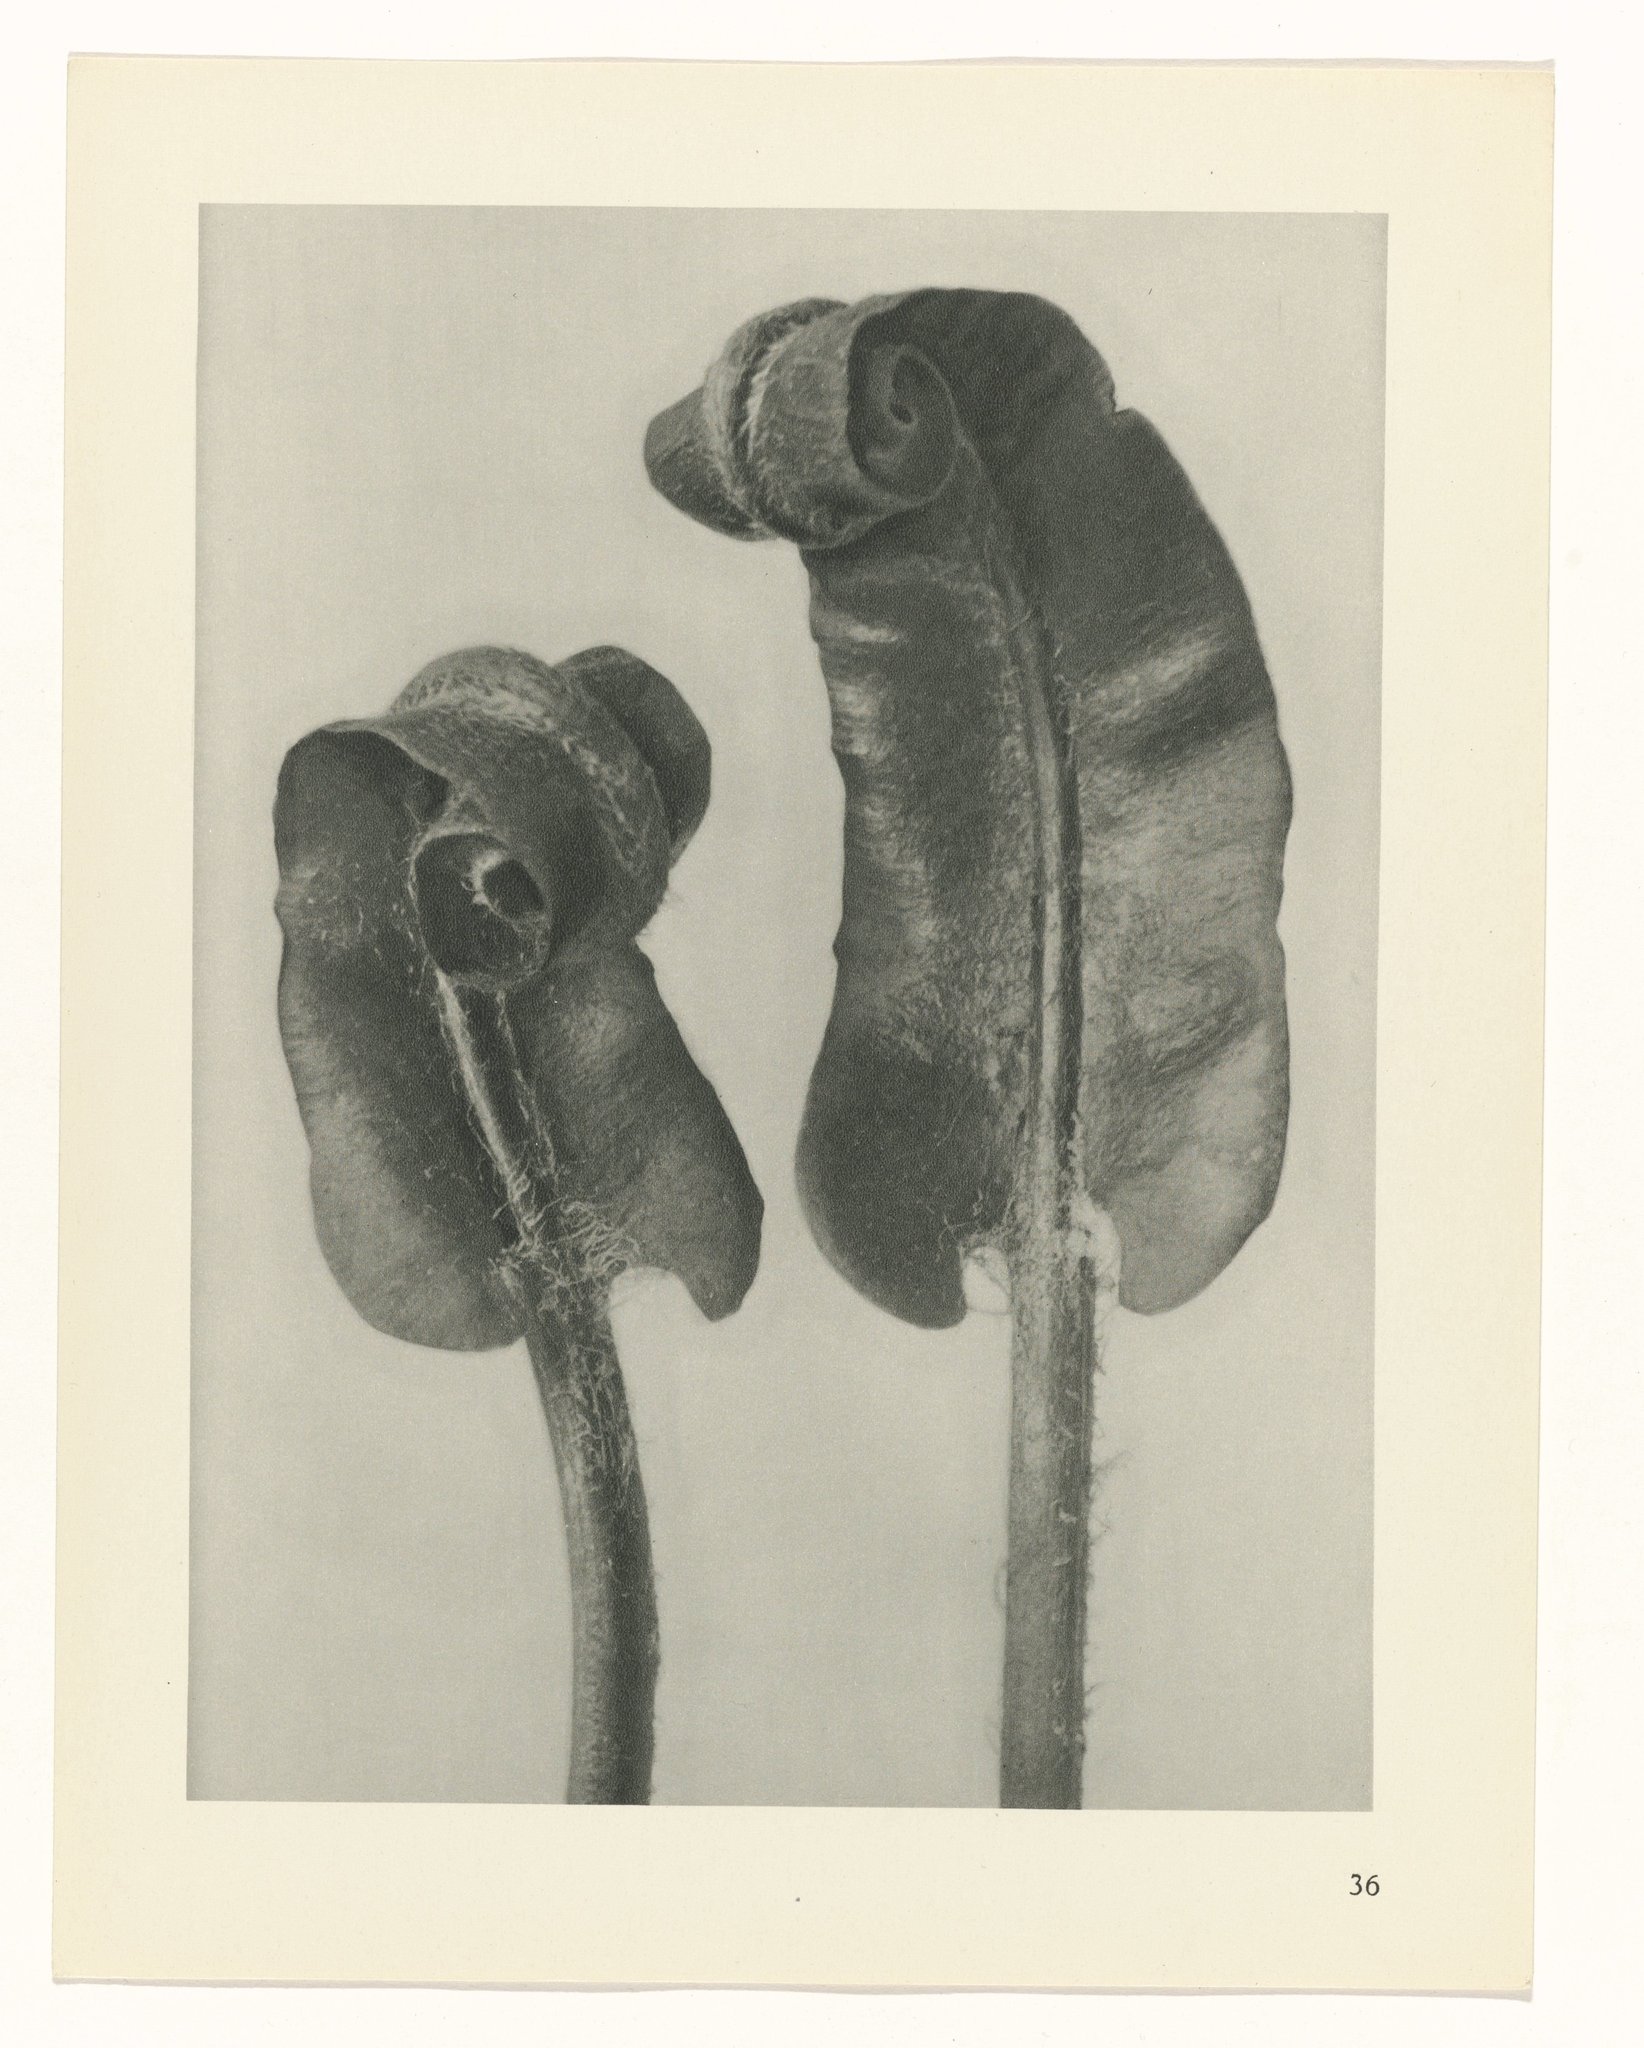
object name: photograph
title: Urformen der Kunst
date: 1928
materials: ink, paper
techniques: rotogravure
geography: berlin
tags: plants (in general)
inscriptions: number: ‘36’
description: facher Vergrößerung. Afkomstig uit losbladige uitgave.